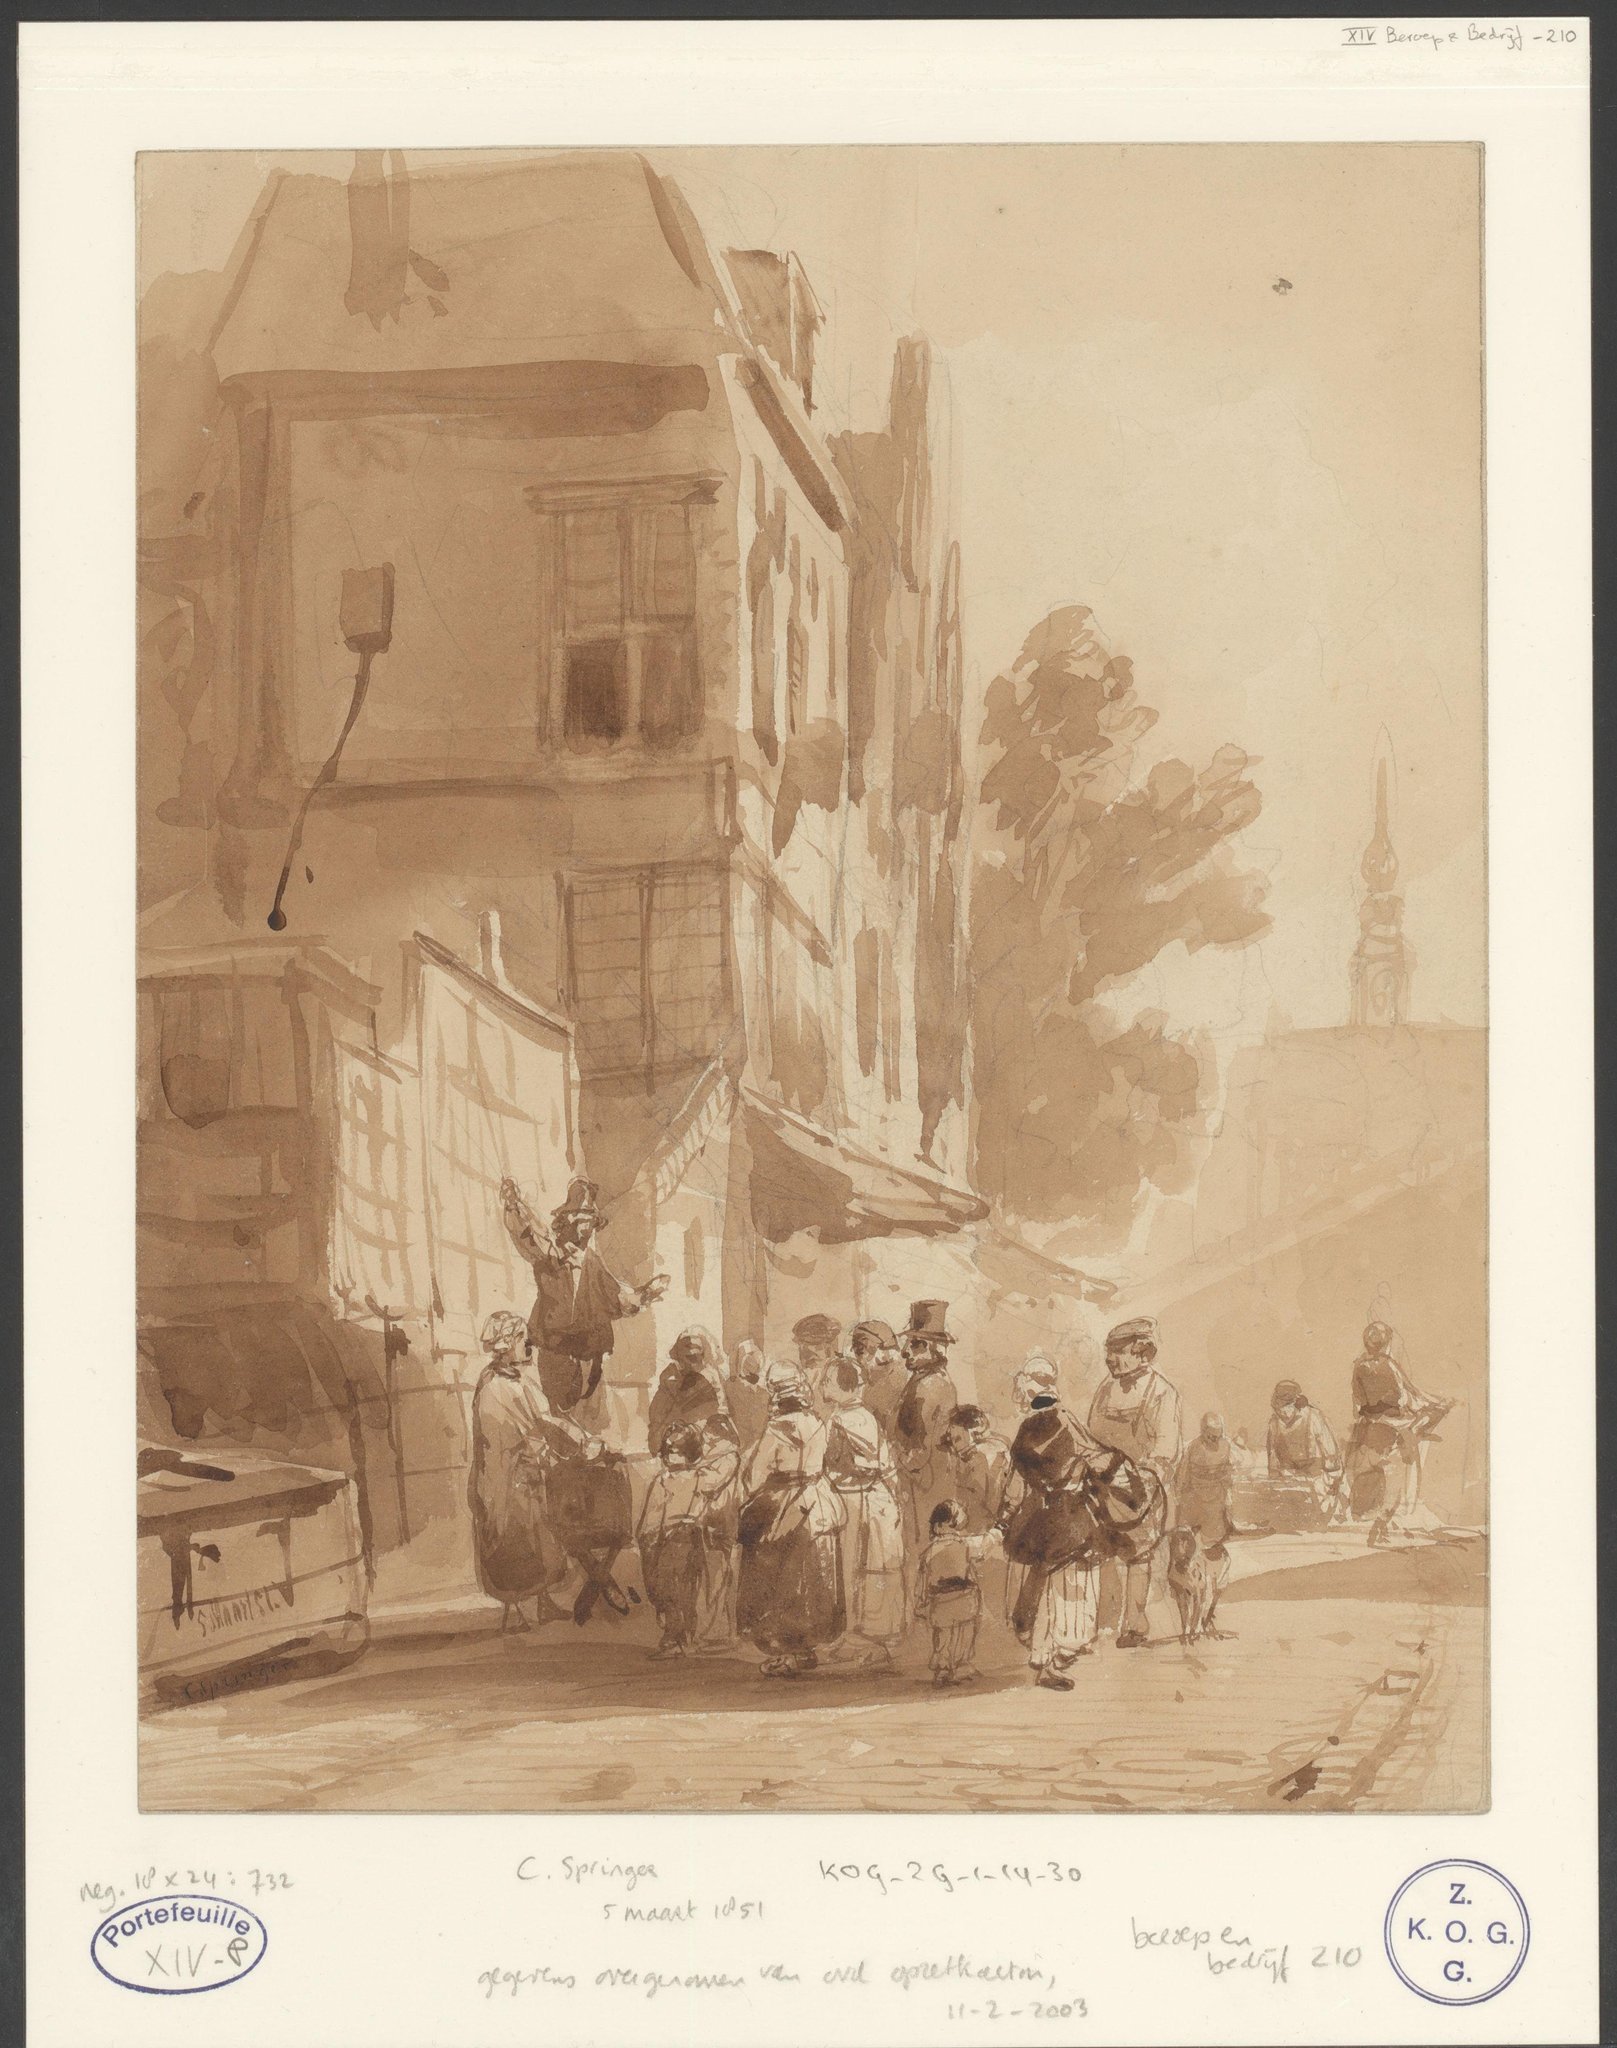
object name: drawing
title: Straatvertoning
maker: cornelis springer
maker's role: draughtsman, painter, print maker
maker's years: 1817-1891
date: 1851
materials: chalk, ink, paper, pencil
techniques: brush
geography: netherlands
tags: quack, charlatan, mountebank, 'saltimbanco', street-trader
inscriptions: collector's mark: Lugt 1641, collector's mark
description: Straatgezicht met straatvertoning. Een man op een podium vertoont zijn kunsten of producten aan een groep mensen verzameld op straat. Onderwerpsrubrieken binnen de Atlas Zeden en Gewoonten: Mannelijk beroep en bedrijf: Marskramers, straatventers, straatslijpers, bedelaars, straatvertooningen enz.